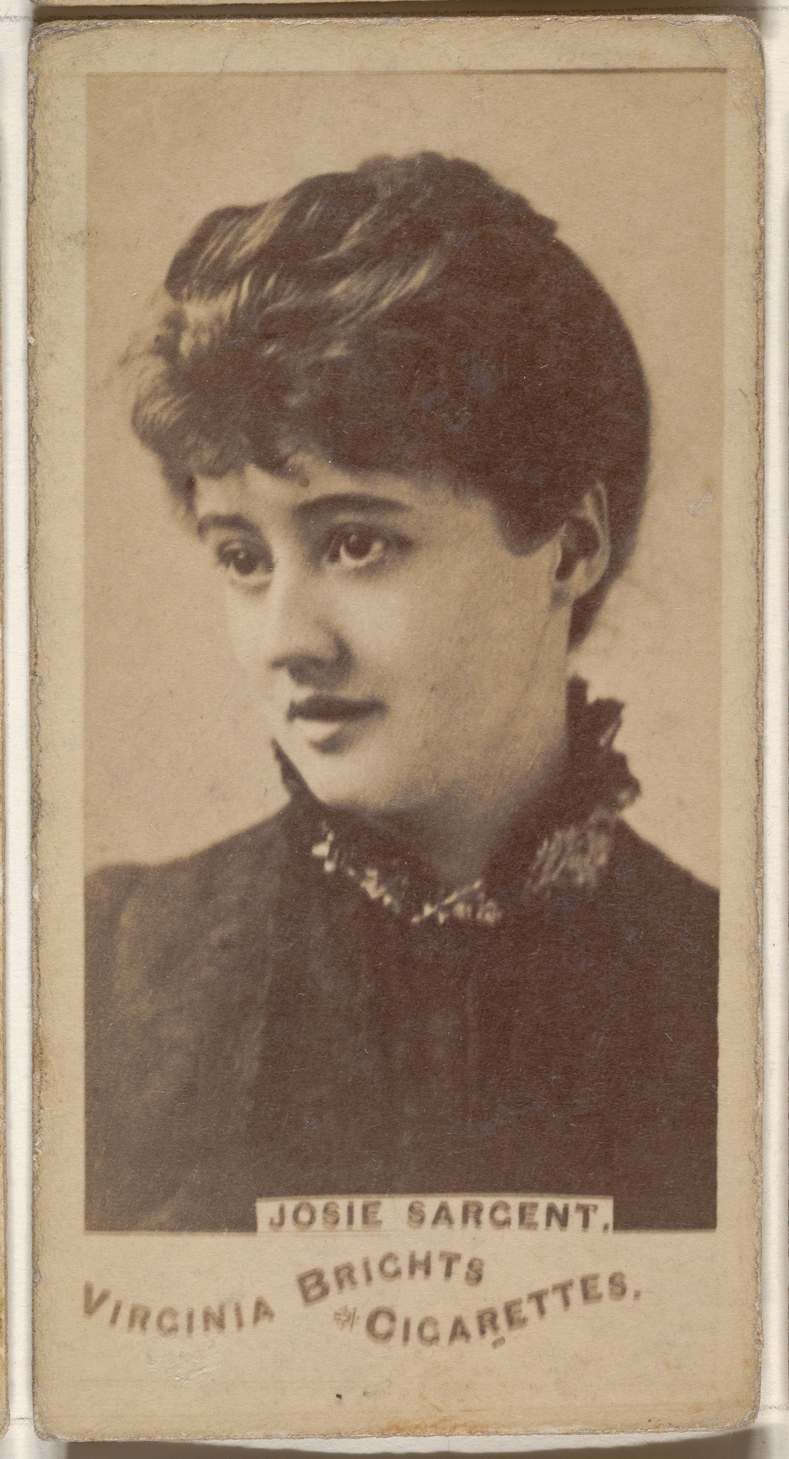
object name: photograph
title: Josie Sargent, from the Actors and Actresses series (N45, Type 1) for Virginia Brights Cigarettes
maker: allen & ginter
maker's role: publisher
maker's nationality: american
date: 1888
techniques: albumen silver print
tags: portraits,women,actresses